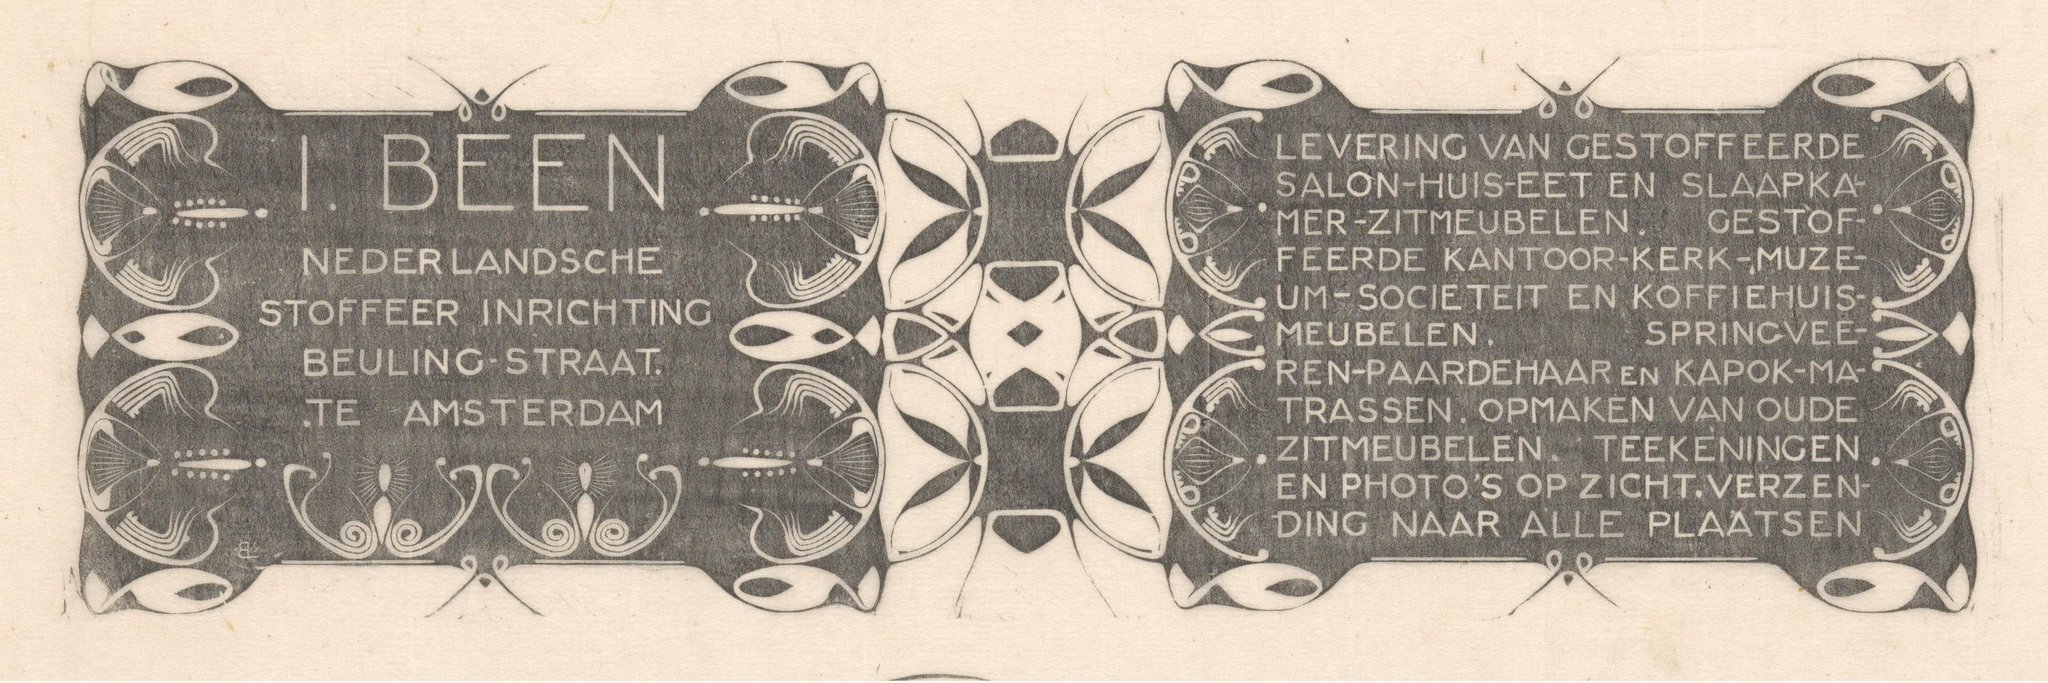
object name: visiting card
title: Visitekaartje van I. Been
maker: karel petrus cornelis de bazel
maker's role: draughtsman, print maker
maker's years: 1869-1923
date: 1898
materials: paper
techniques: woodcut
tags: visiting-card, calling-card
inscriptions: collector's mark: Lugt 2228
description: Voor- en achterzijde van een annoncekaart van I. Been, een stoffeerinrichting aan de Beulingstraat in Amsterdam.